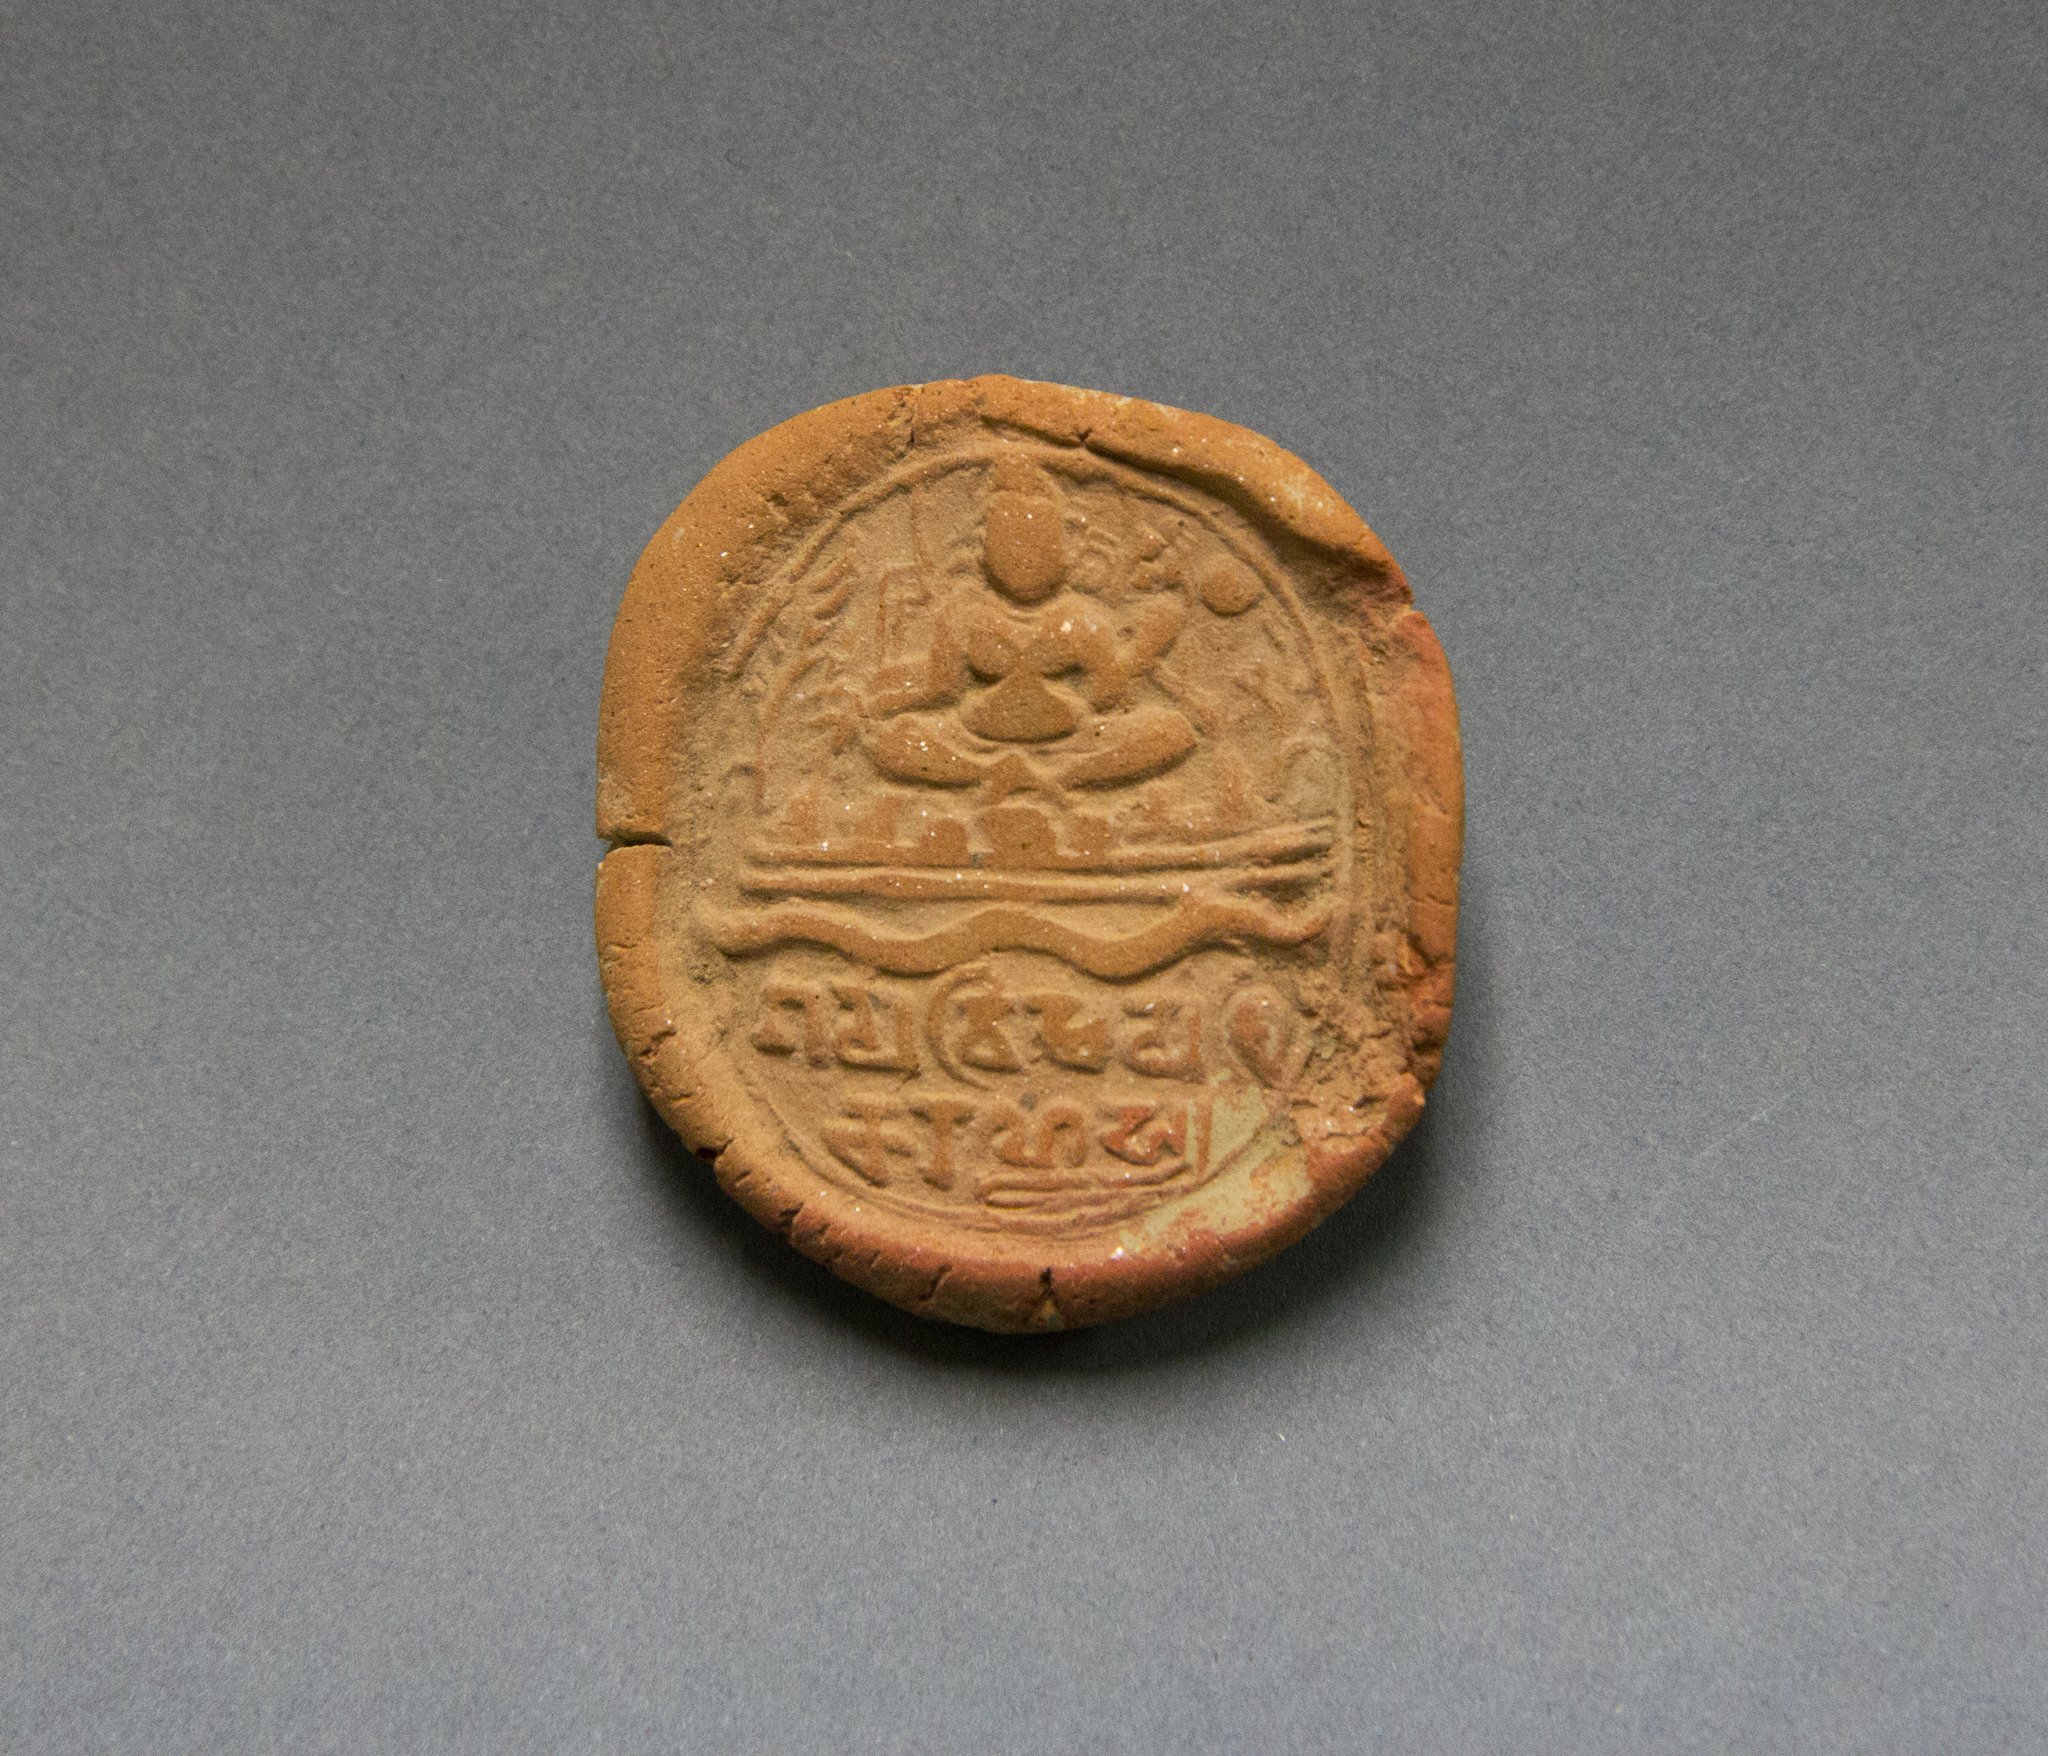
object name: seal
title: Round Seal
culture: indian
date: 401-500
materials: terracotta